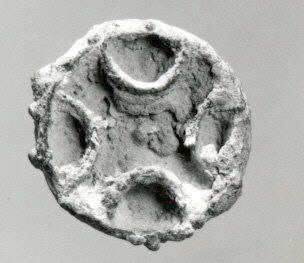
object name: stamp seal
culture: bactria-margiana archaeological complex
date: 2333-1668 BCE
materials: copper alloy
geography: bactria-margiana